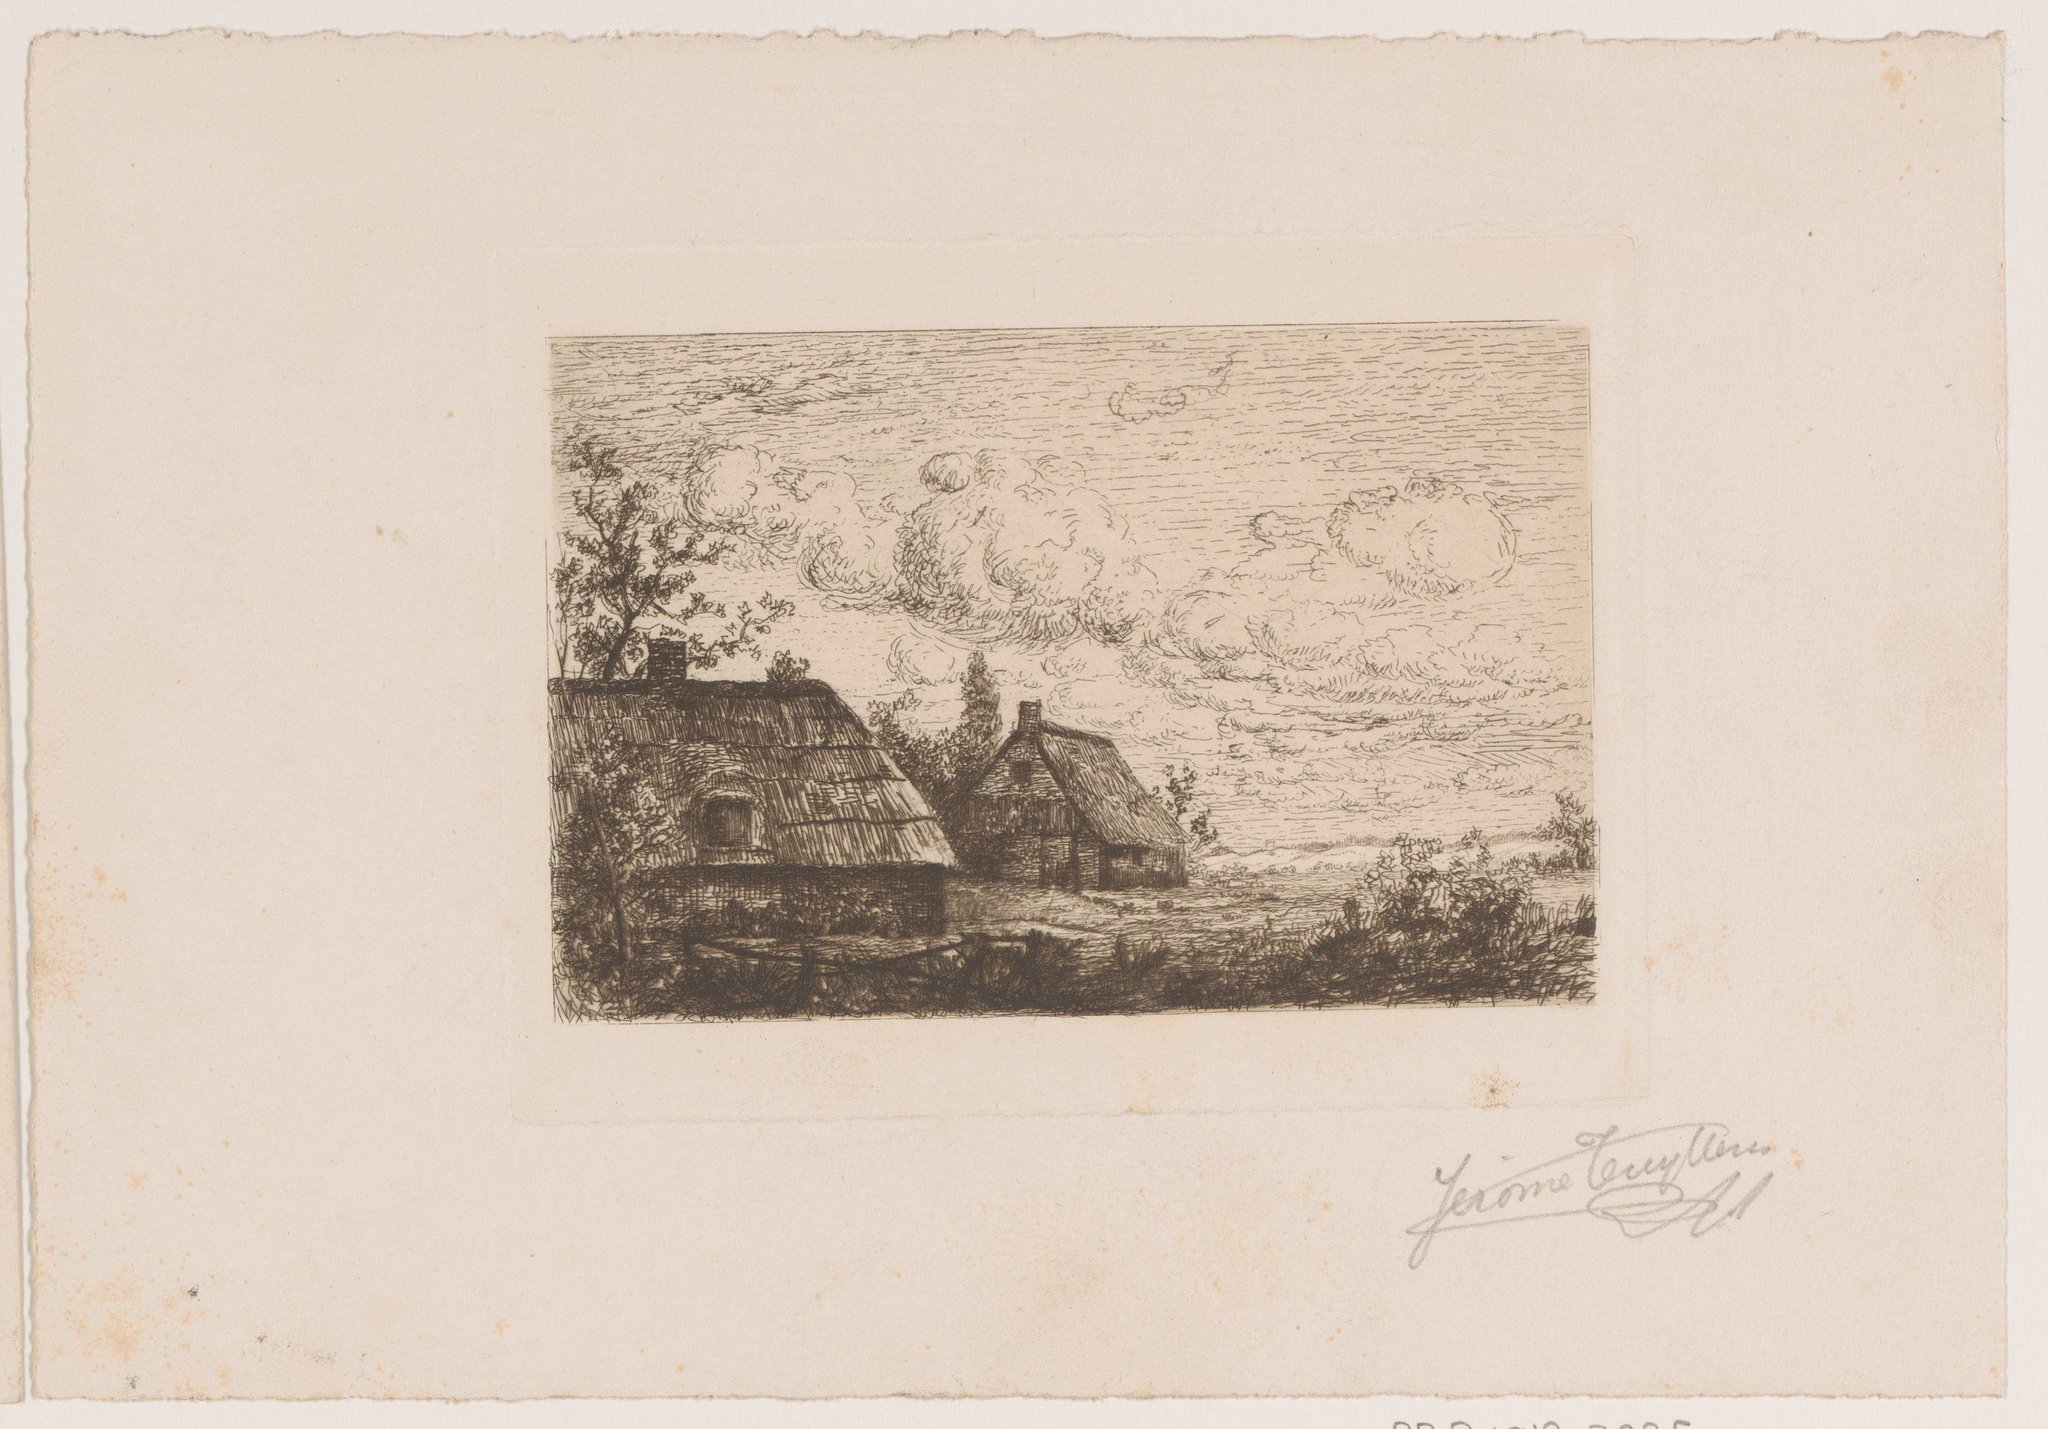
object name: print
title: Landschap met twee boerderijen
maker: jerôme tuyttens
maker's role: painter, print maker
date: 1850-1883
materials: paper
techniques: drypoint, etching, intaglio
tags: farm or solitary house in landscape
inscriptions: collector's mark: Lugt 2228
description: Sterfdatum van de prentmaker is onbekend. Daarom is voor de bepaling van de rechten van dit object gebruik gemaakt van de verwervingsdatum Rijksmuseum Amsterdam.